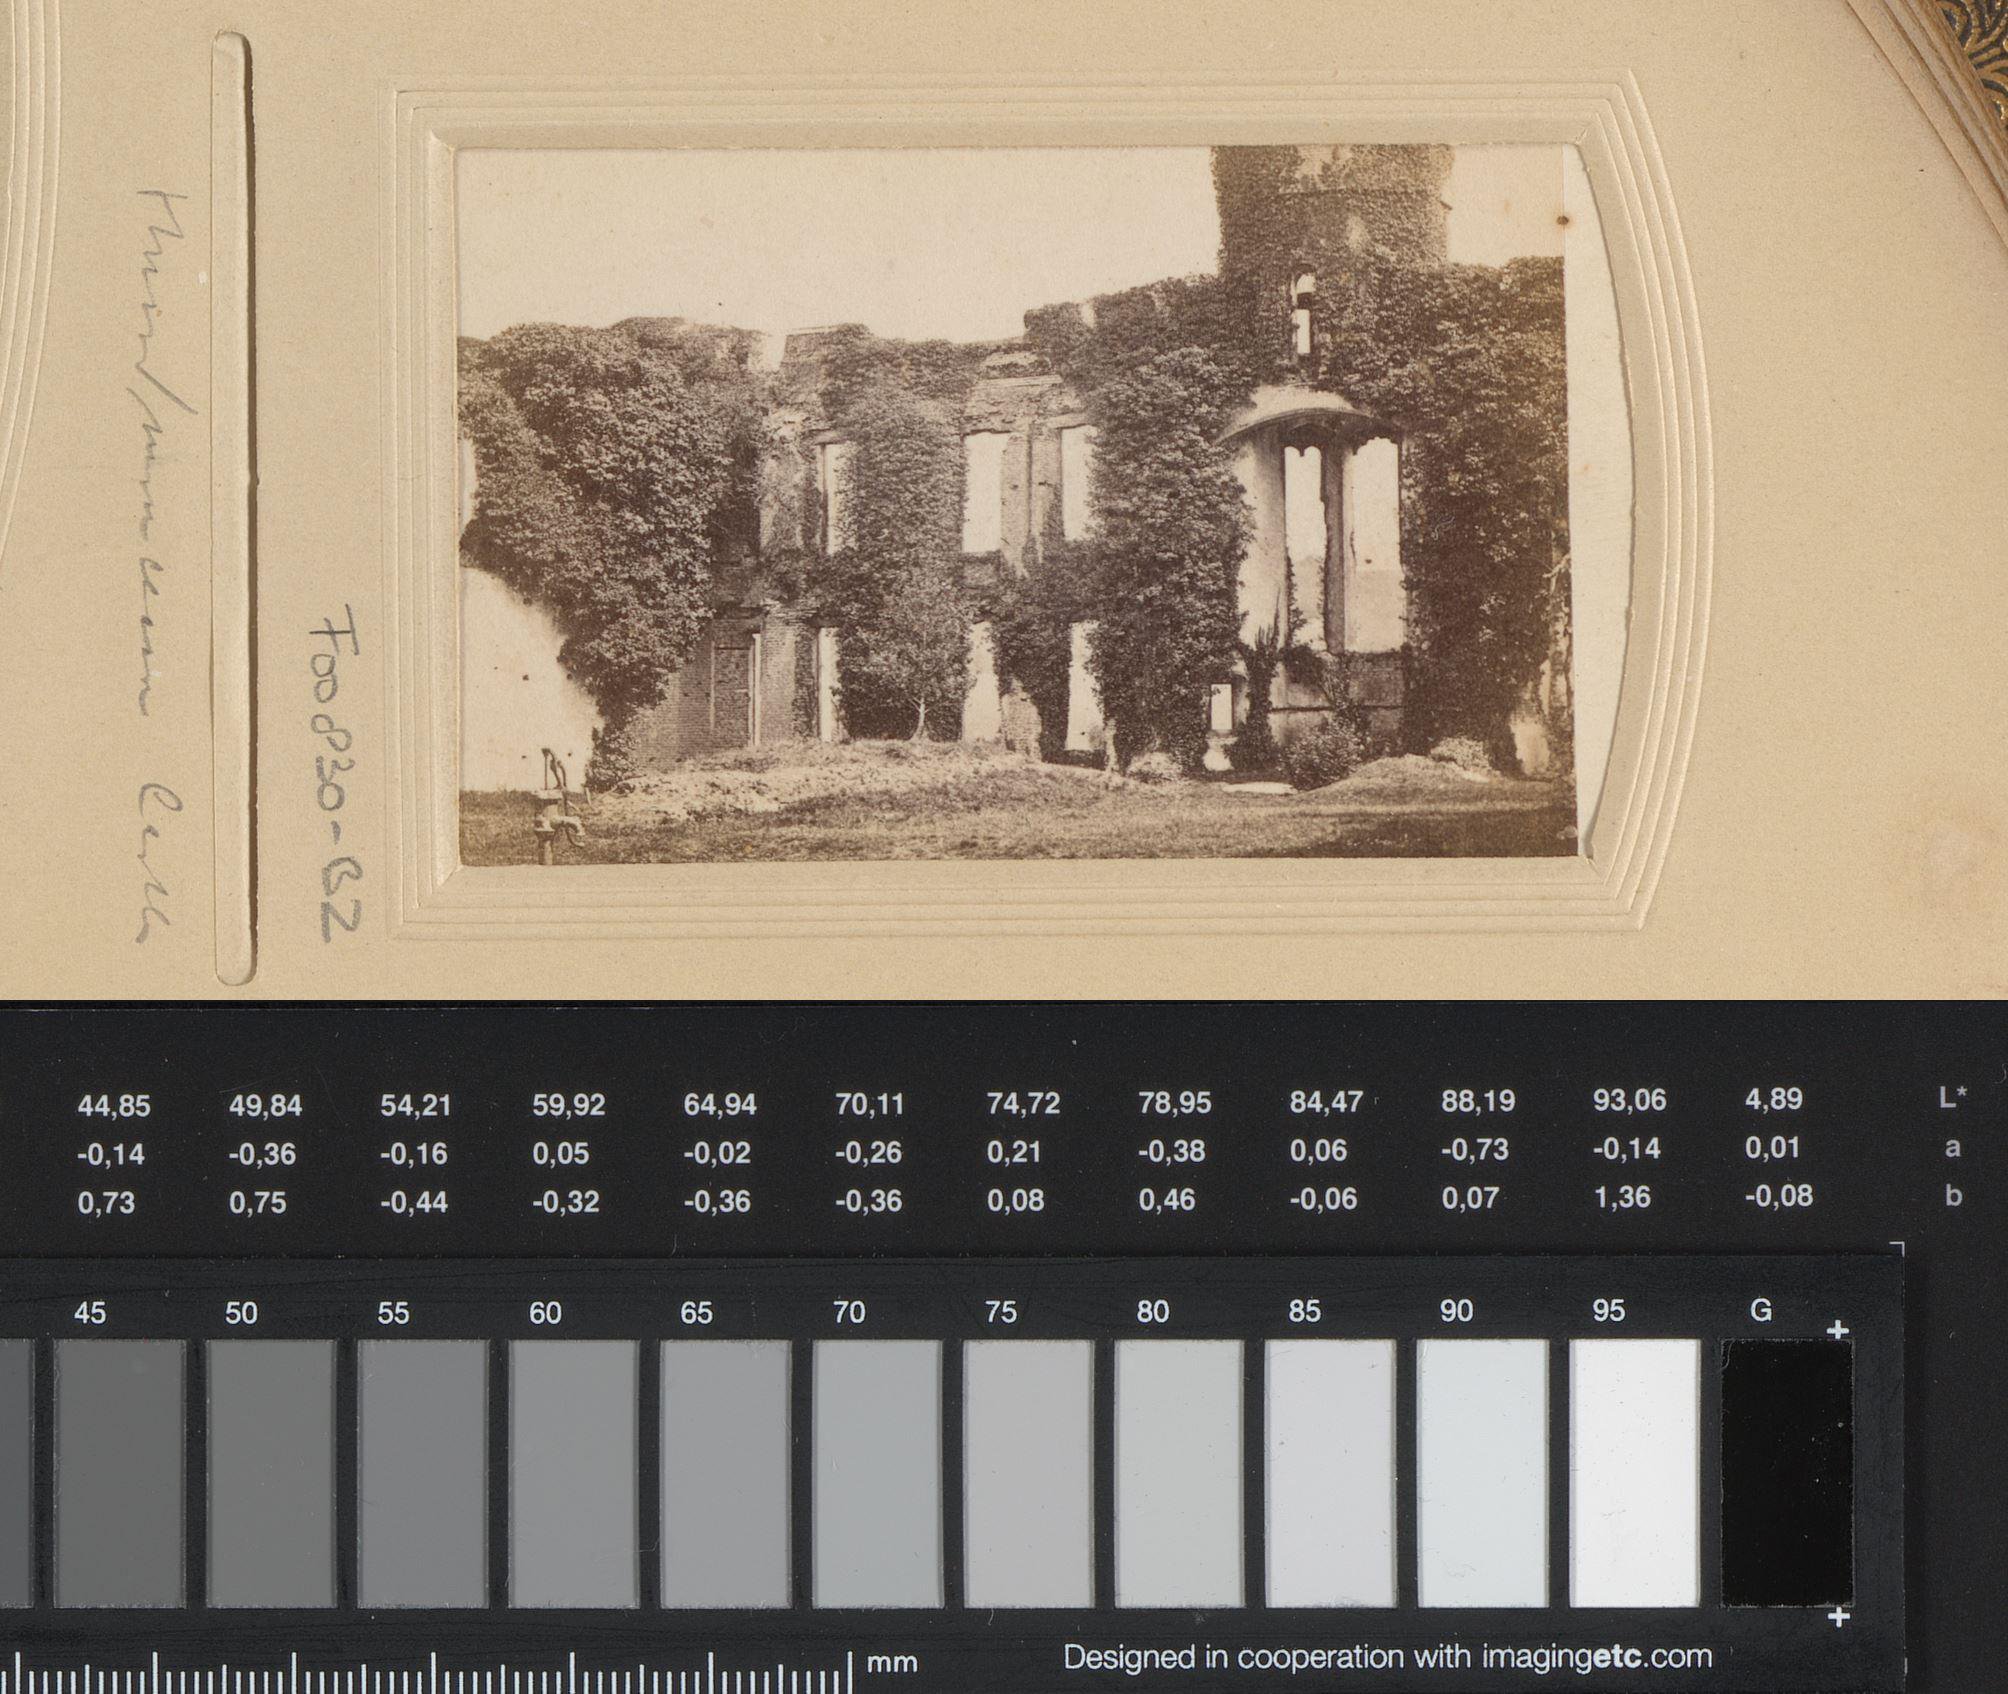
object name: carte de visite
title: Ruïnes van Herstmonceux Castle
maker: frances sutherland mann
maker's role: fotograaf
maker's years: 1867-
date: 1870-1900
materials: cardboard, photographic support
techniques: albumen print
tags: ruin of a dwelling, house, castle, etc., plants and herbs: ivy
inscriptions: annotation: ‘Herstmonceux Castle’, inscription: ‘F.S. Mann/ Photographic/ Artist/ 13/ Wellington/ Place/ Hastings’